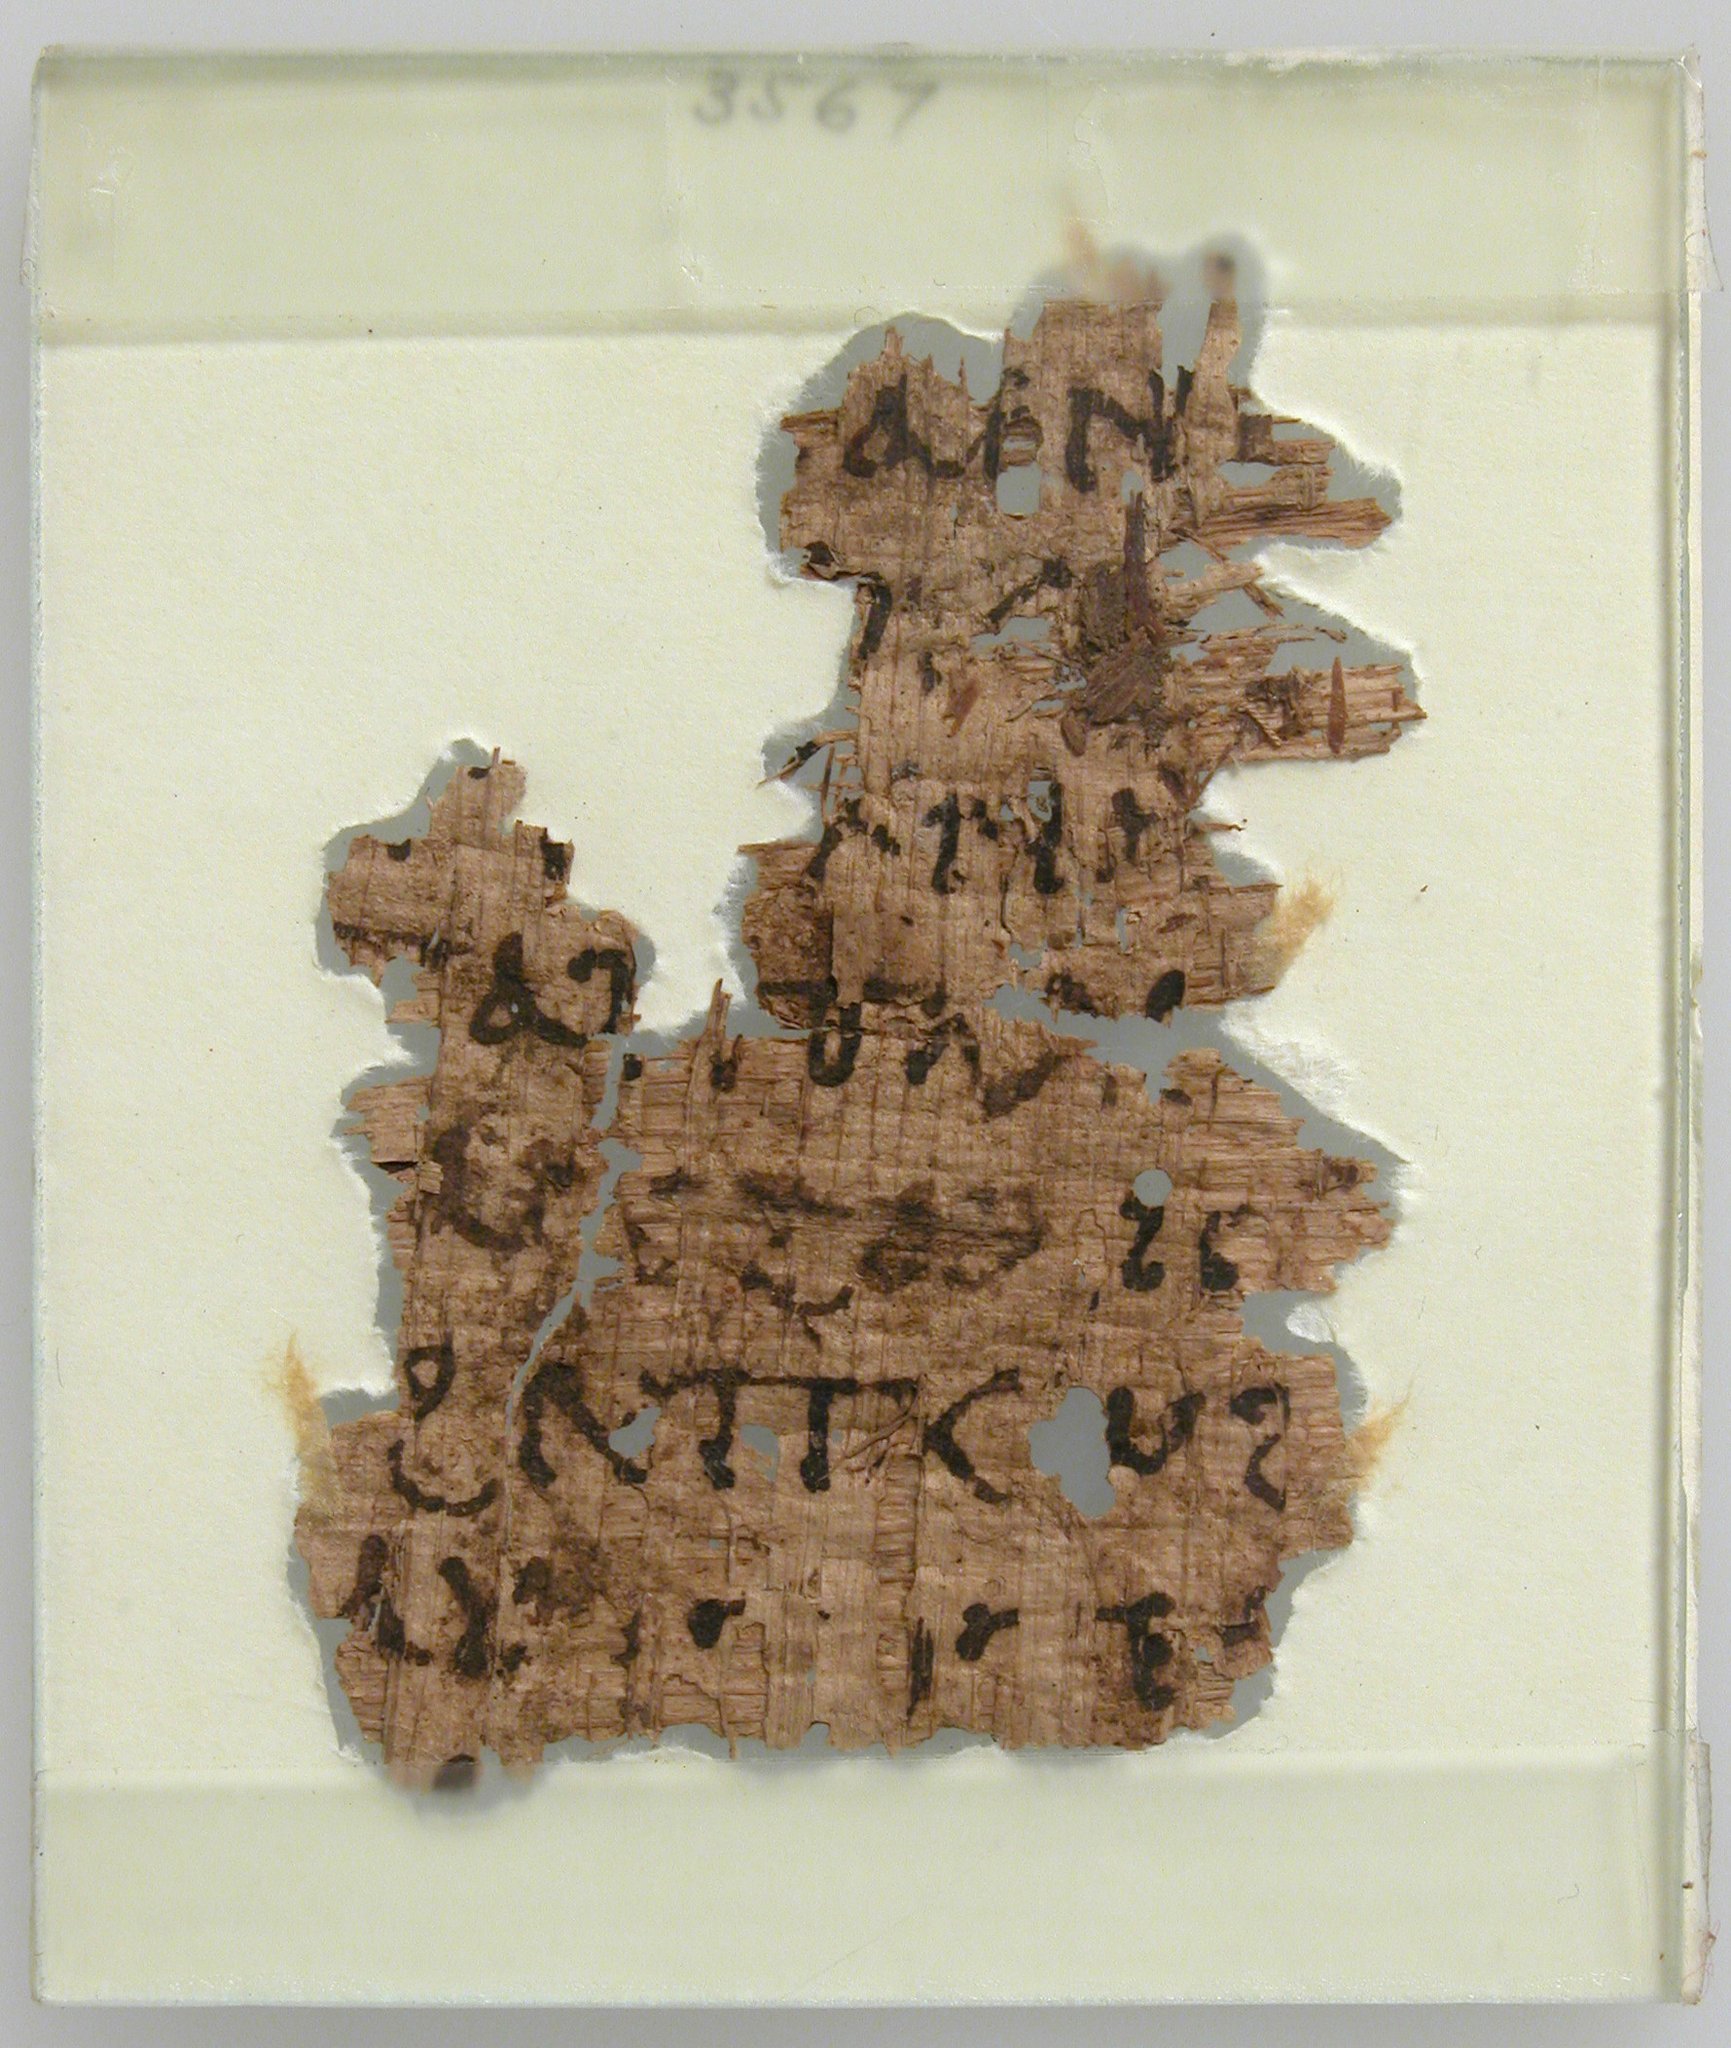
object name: fragment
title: Papyrus Fragment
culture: coptic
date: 301-700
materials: ink, papyrus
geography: egypt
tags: documents